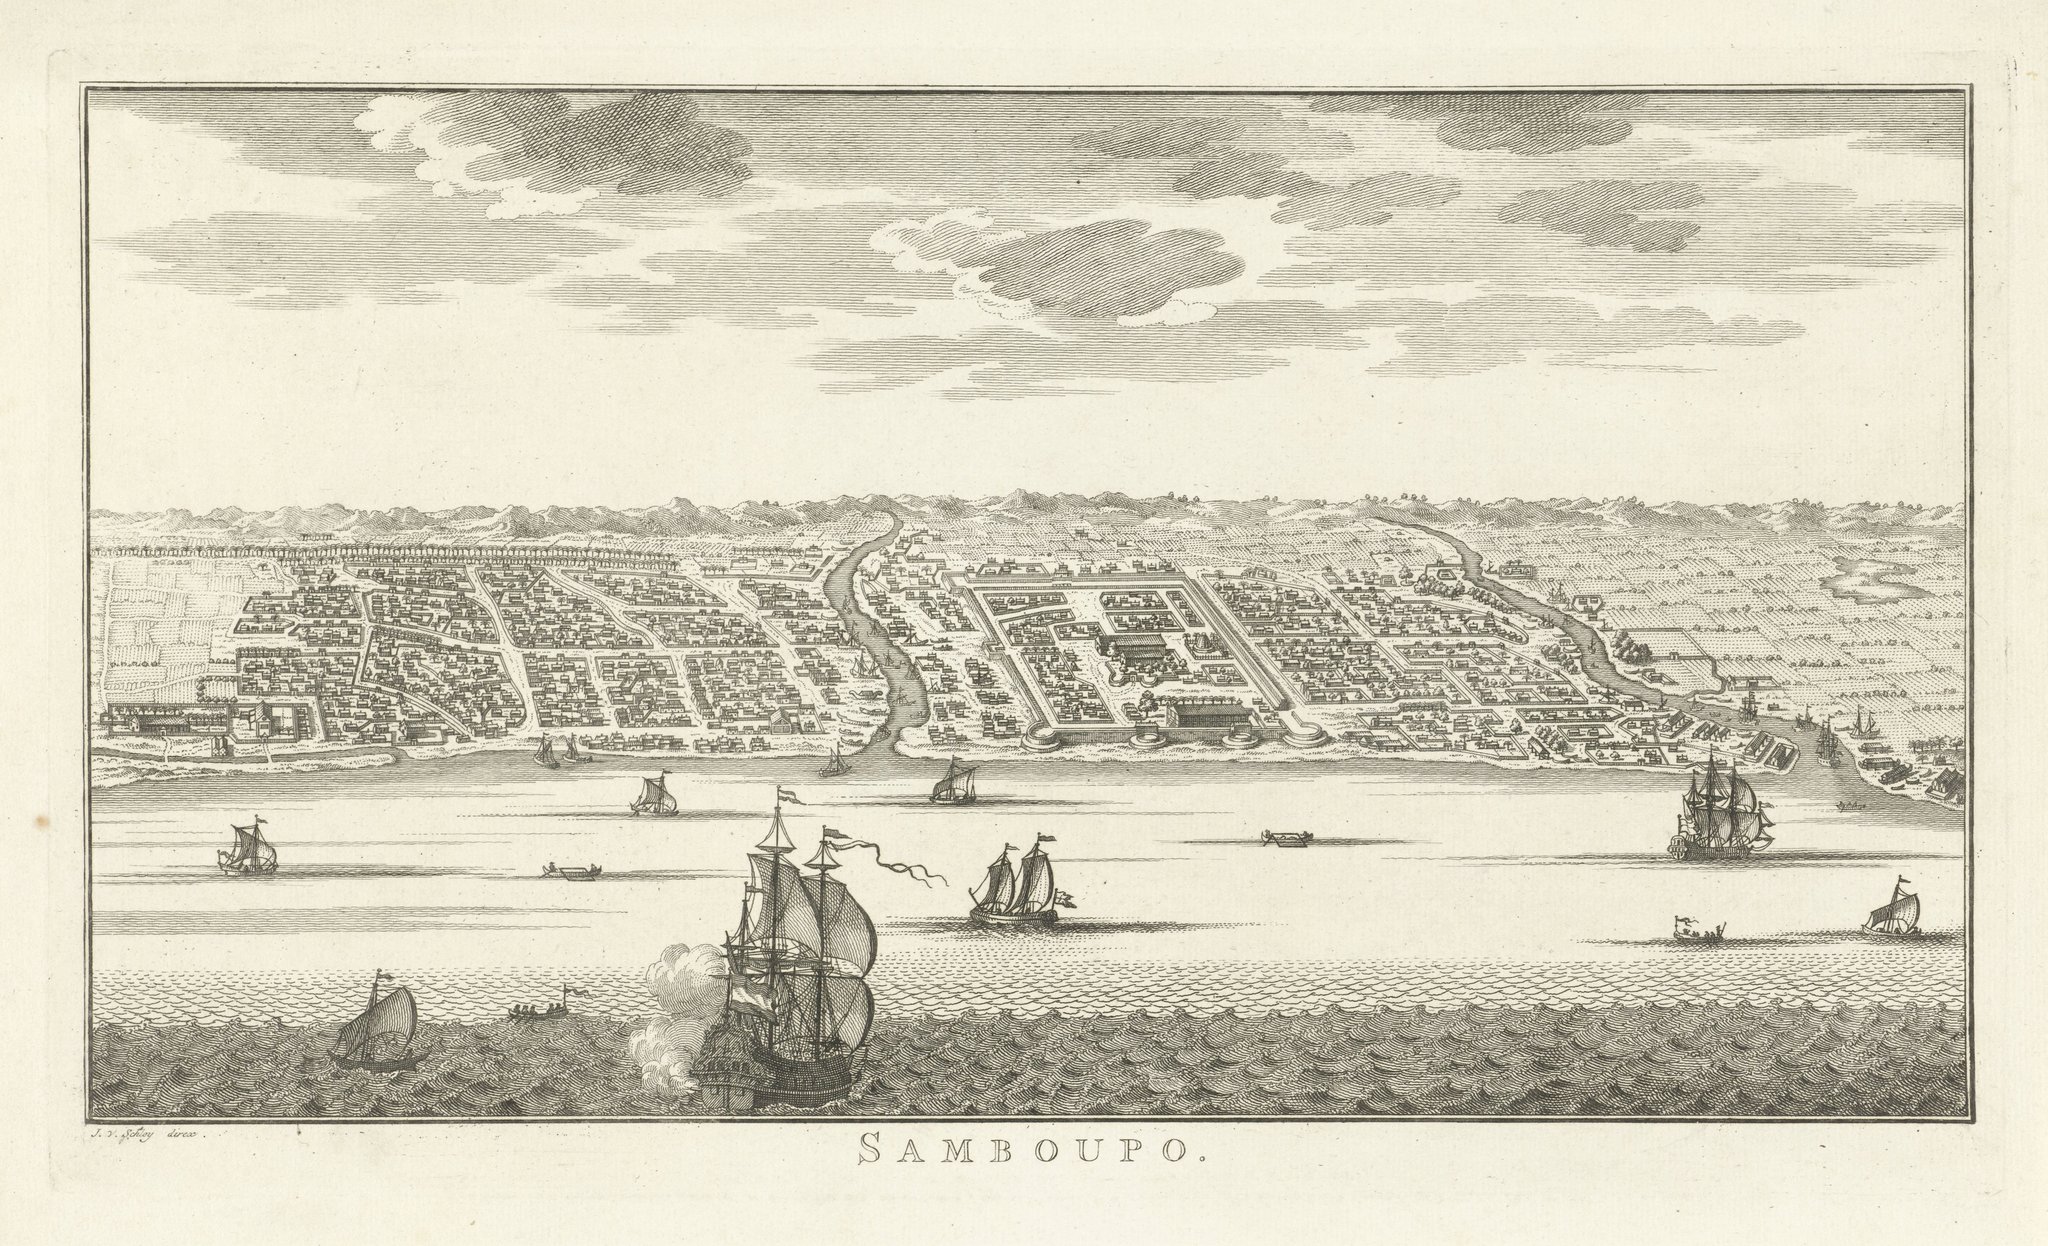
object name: print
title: Sampoupo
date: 1747-1779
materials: paper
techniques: engraving, etching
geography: the hague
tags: sailing-ship, sailing-boat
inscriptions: collector's mark: Lugt 2228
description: Gezicht vanuit vogelperspectief op de stad Makassar, met op de voorgrond verschillende schepen waaronder enkele met de Nederlandse vlag. De stad Makassar wordt op de prent Samboupo genoemd, hetgeen eigenlijk de benaming voor het kasteel van de vorst van Macasar was.